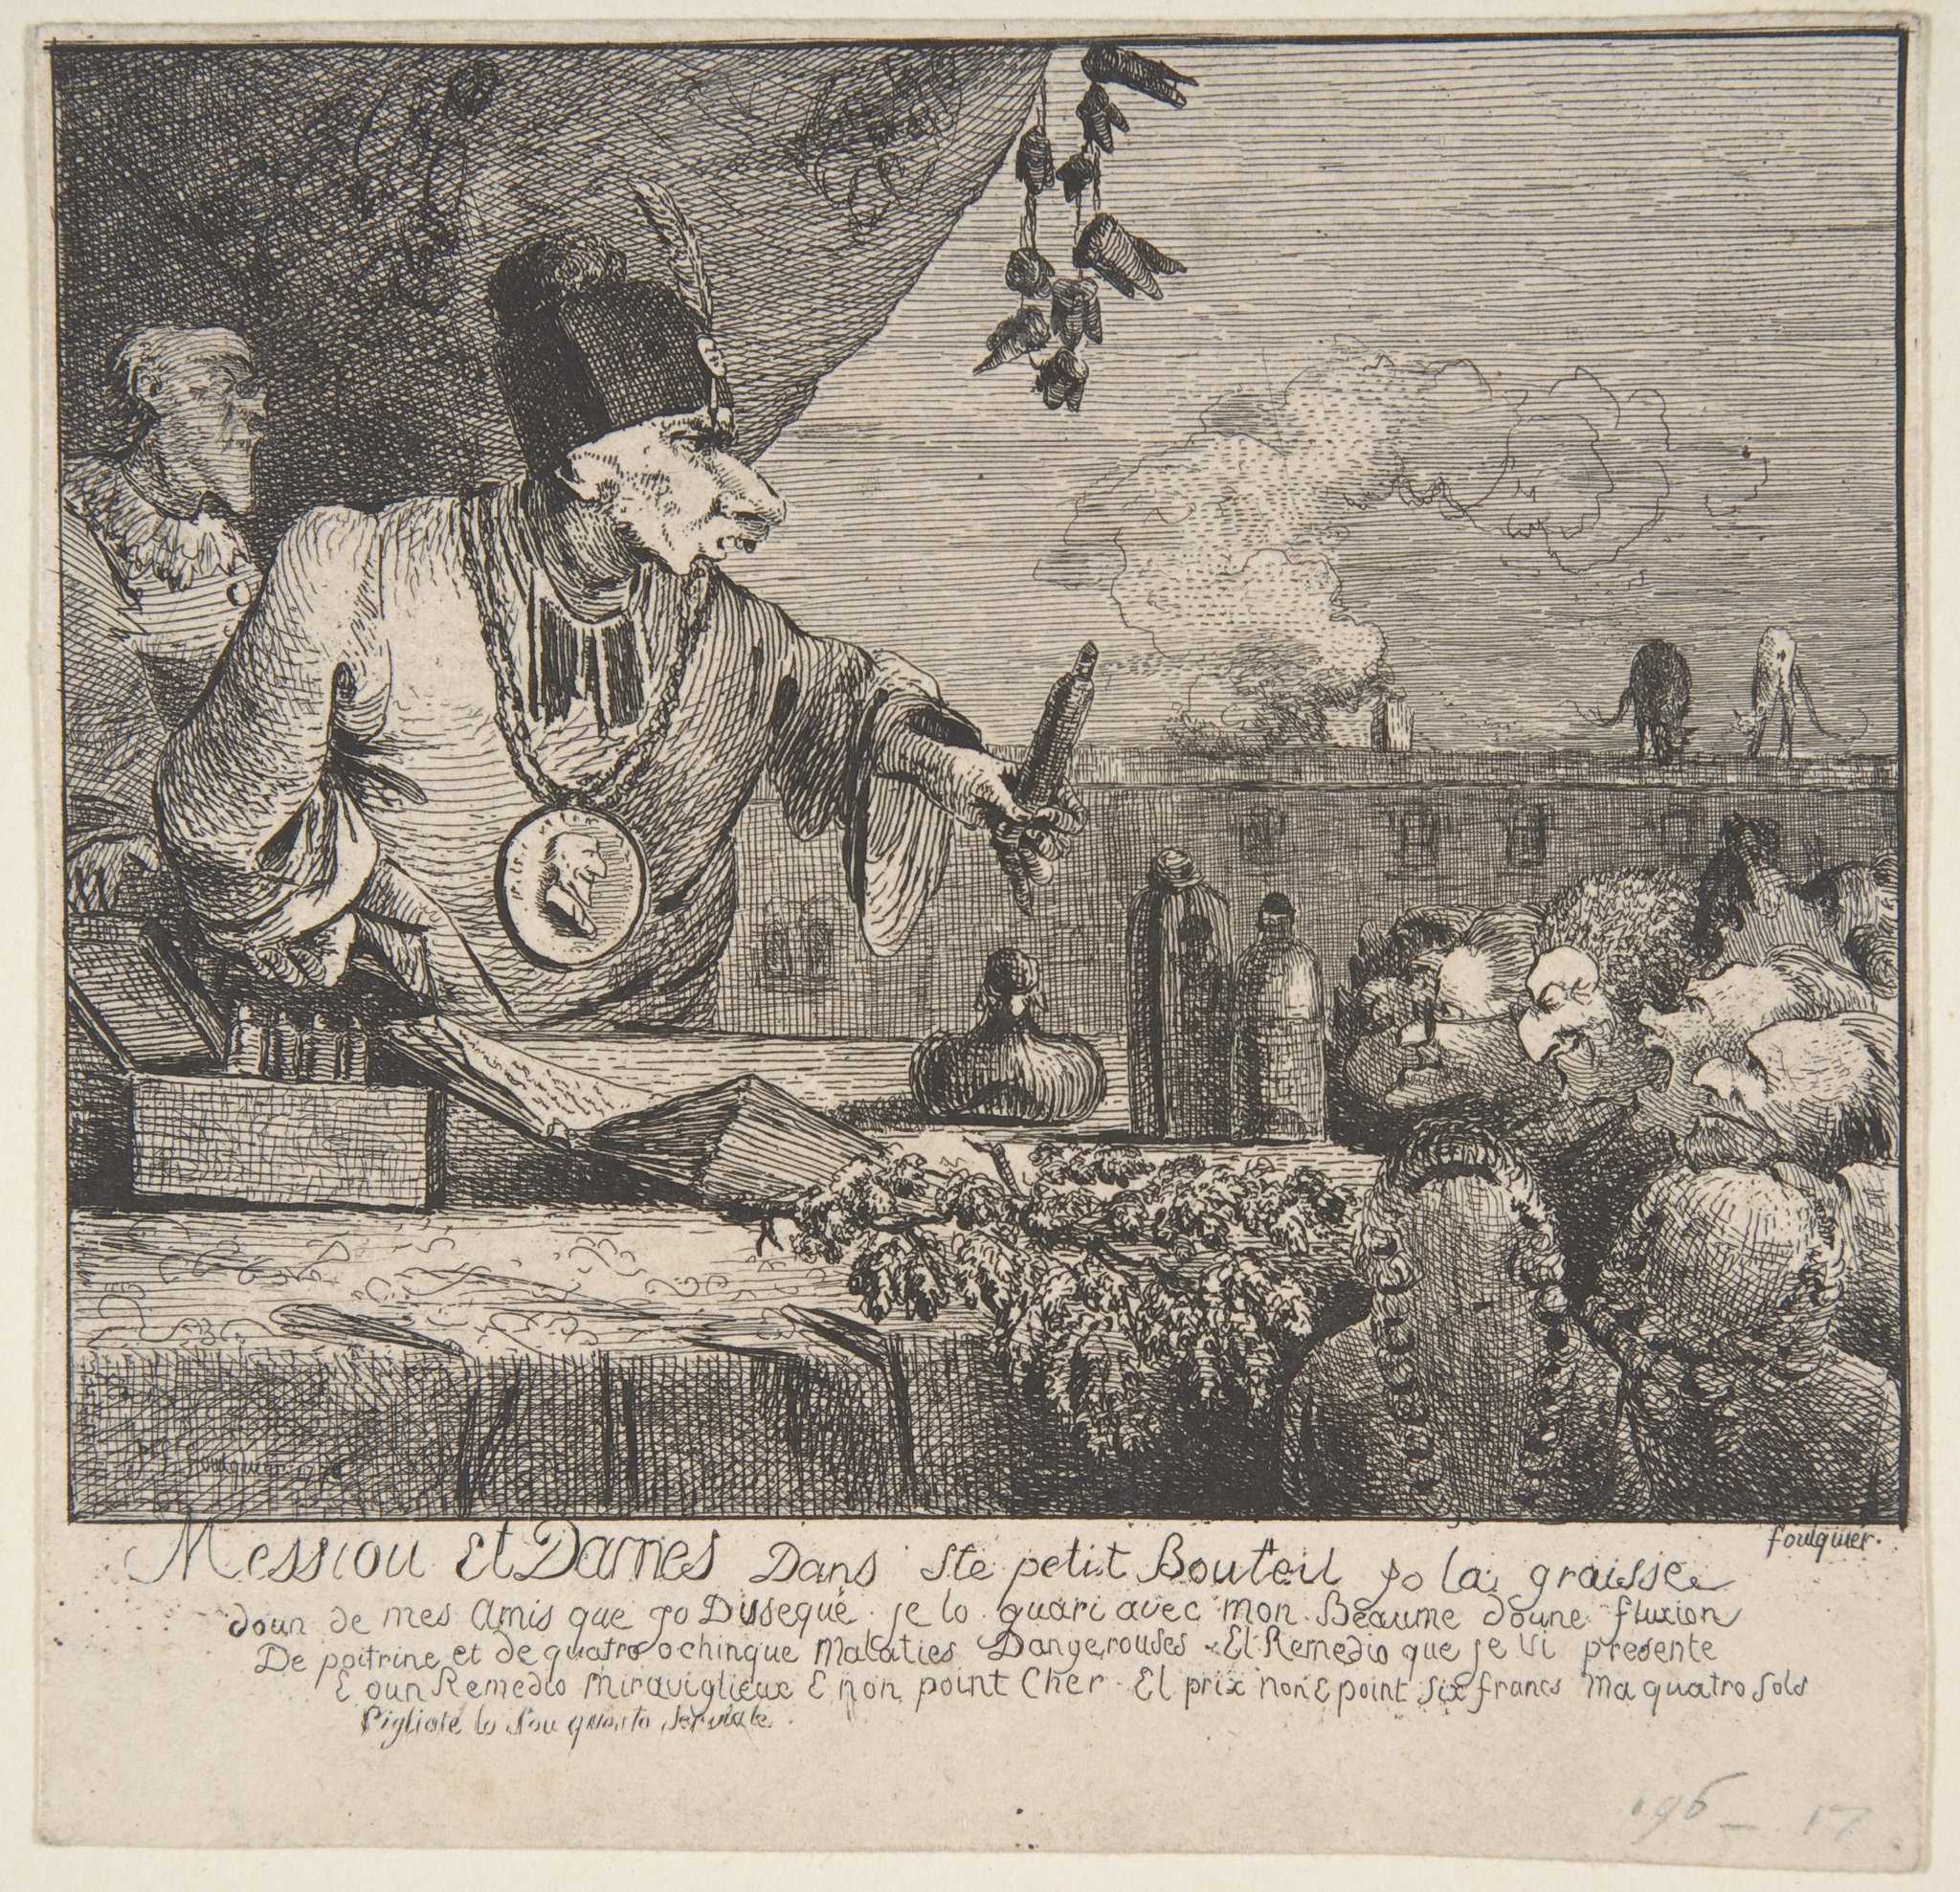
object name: print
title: Ladies and Gentlemen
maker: joseph françois foulquier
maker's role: artist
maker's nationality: french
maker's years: 1744-1789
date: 1776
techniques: etching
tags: men,women,crowd